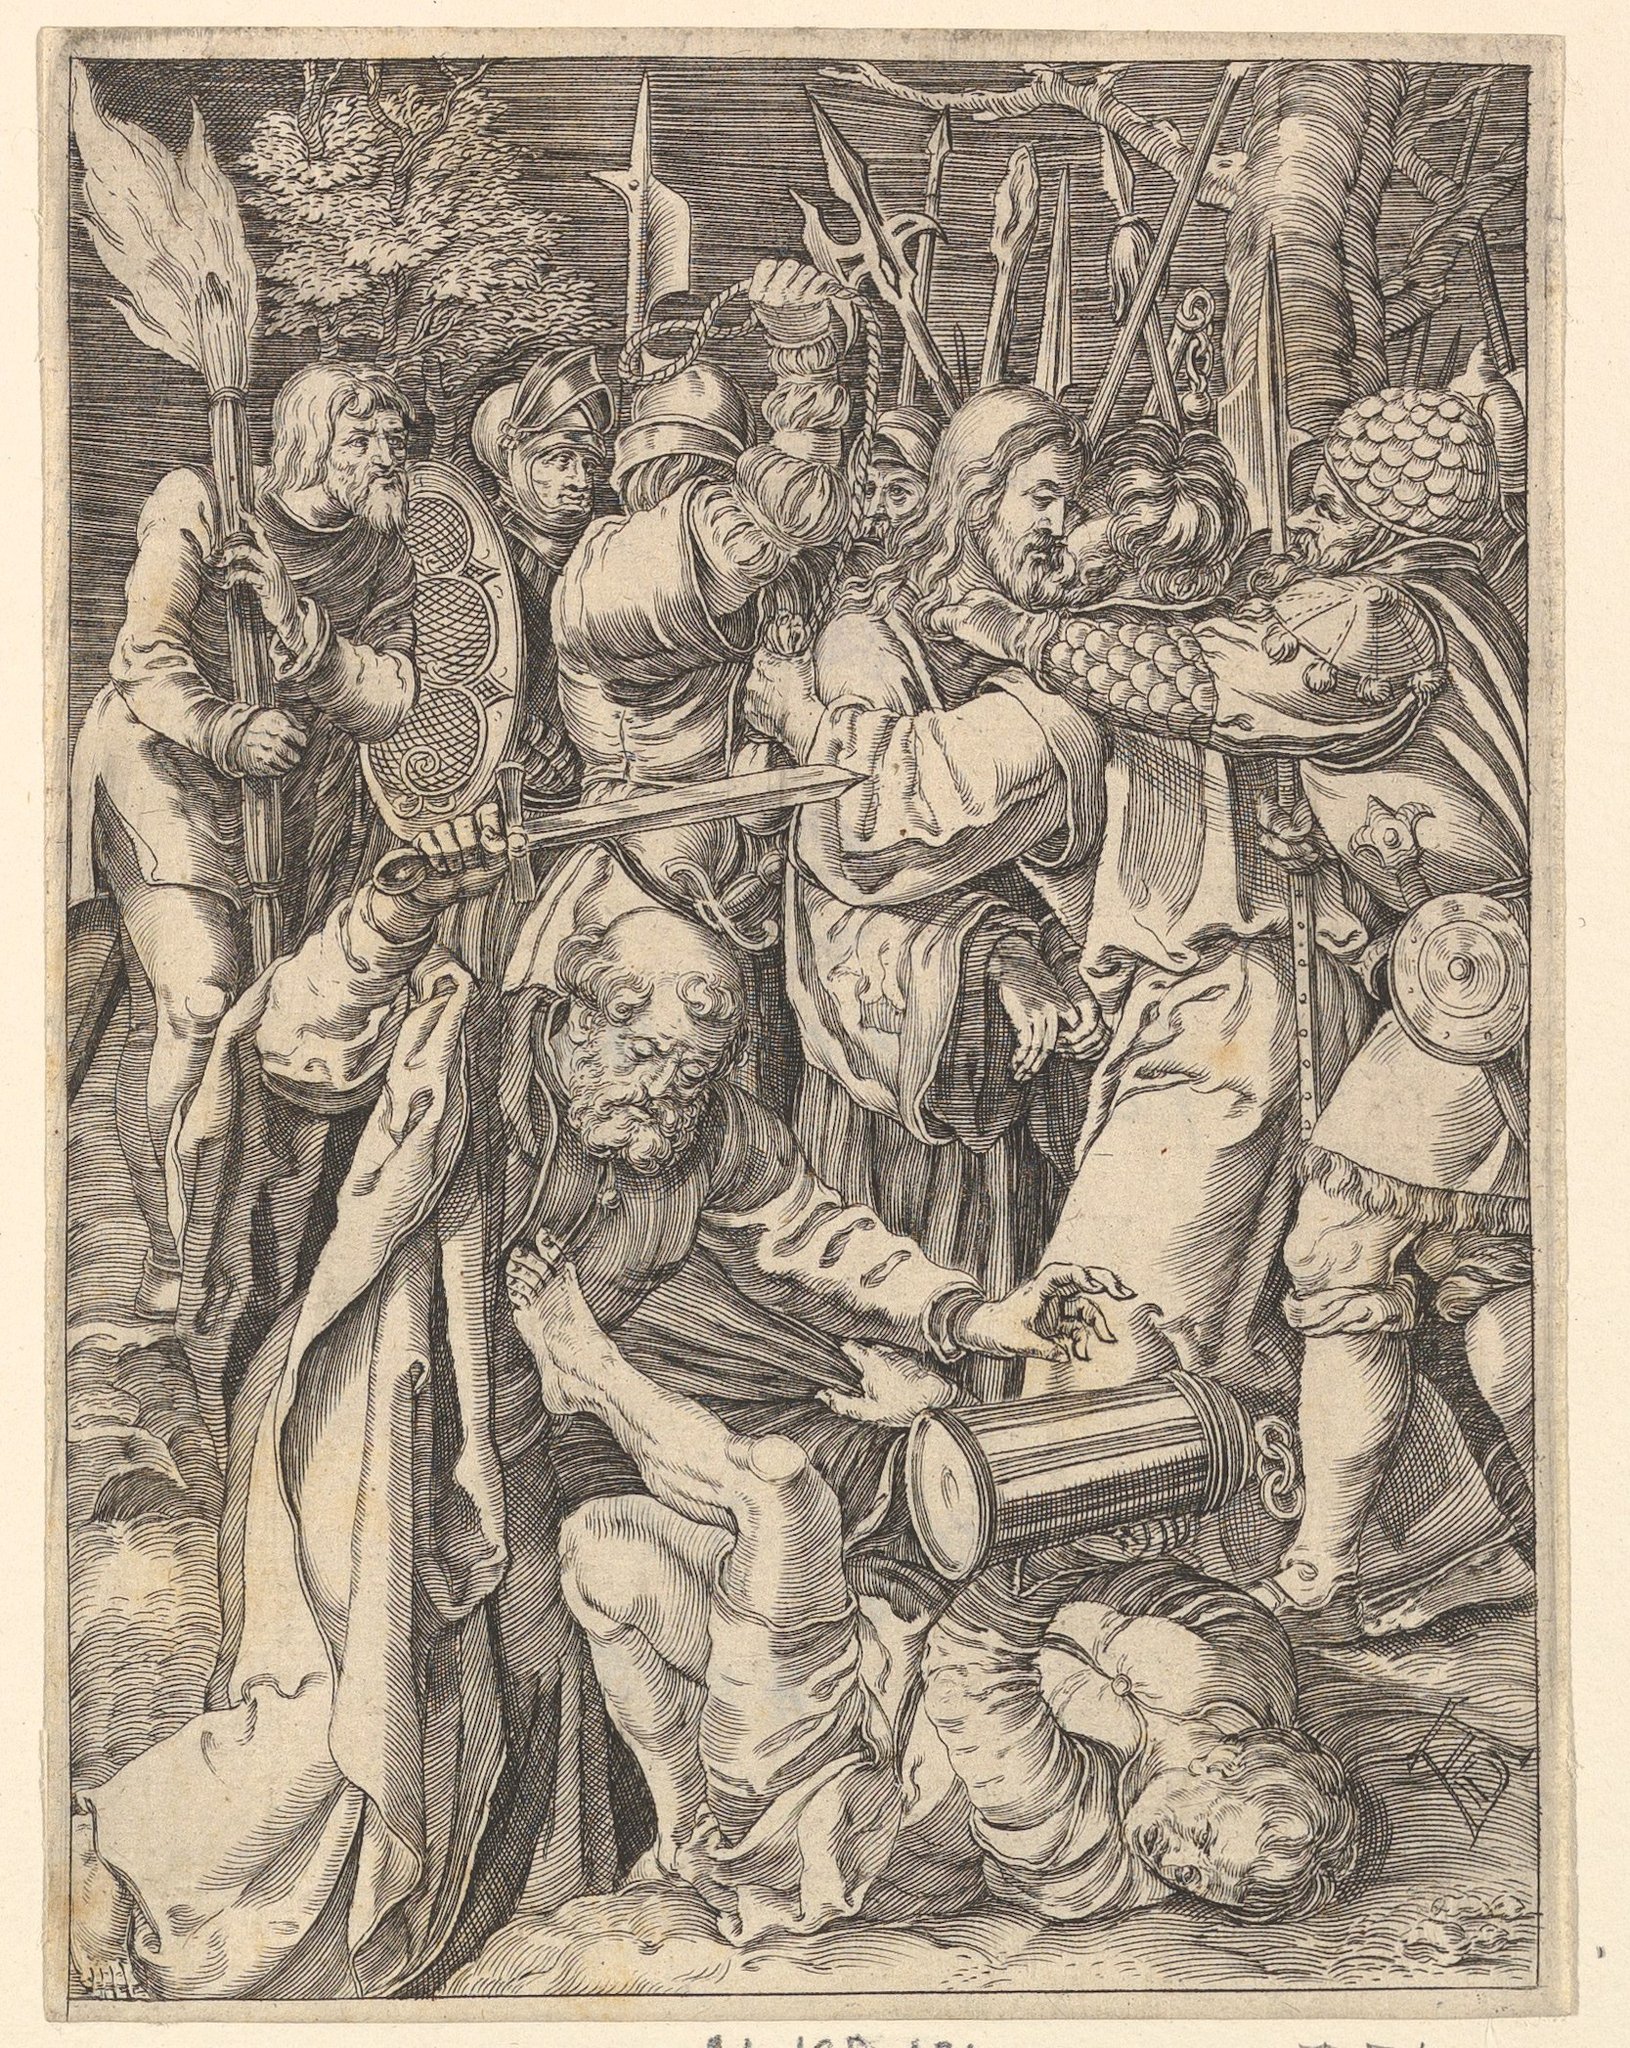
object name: print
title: Engraved copies of The Little Passion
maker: albrecht dürer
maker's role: artist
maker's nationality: german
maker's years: 1471-1528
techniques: engraving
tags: soldiers,spears,men,christ